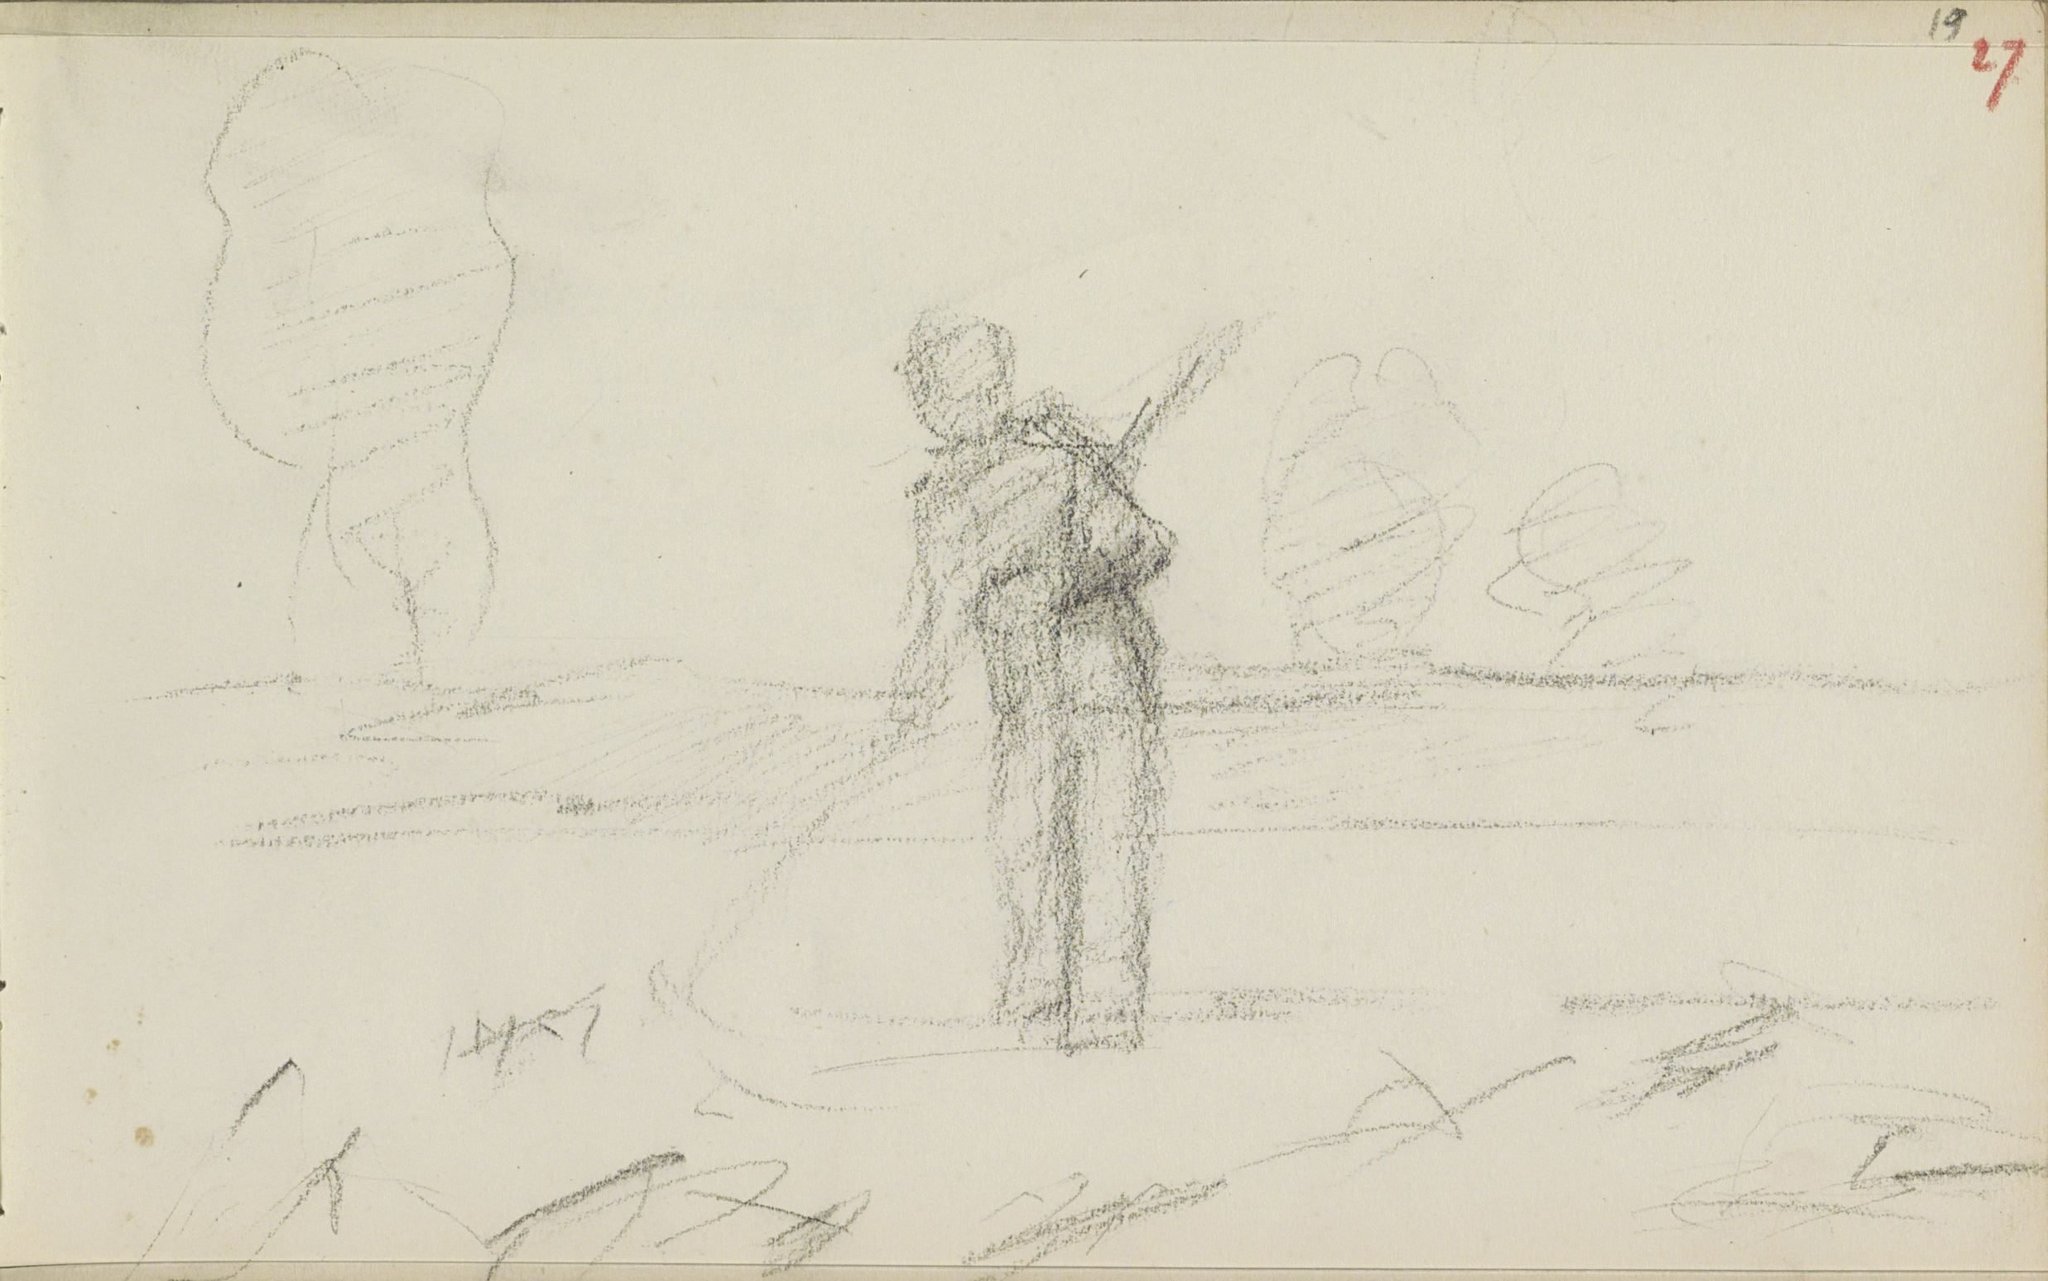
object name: sketchbook leaf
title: Schelpenvisser of een landarbeider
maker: jozef israëls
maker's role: draughtsman, painter, print maker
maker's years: 1824-1911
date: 1834-1911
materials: chalk, paper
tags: landscapes (+ landscape with figures, staffage)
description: De figuur heeft een stuk gereedschap, mogelijk een hark of net, in de handen. Blad 19 recto uit een schetsboek met 37 bladen.